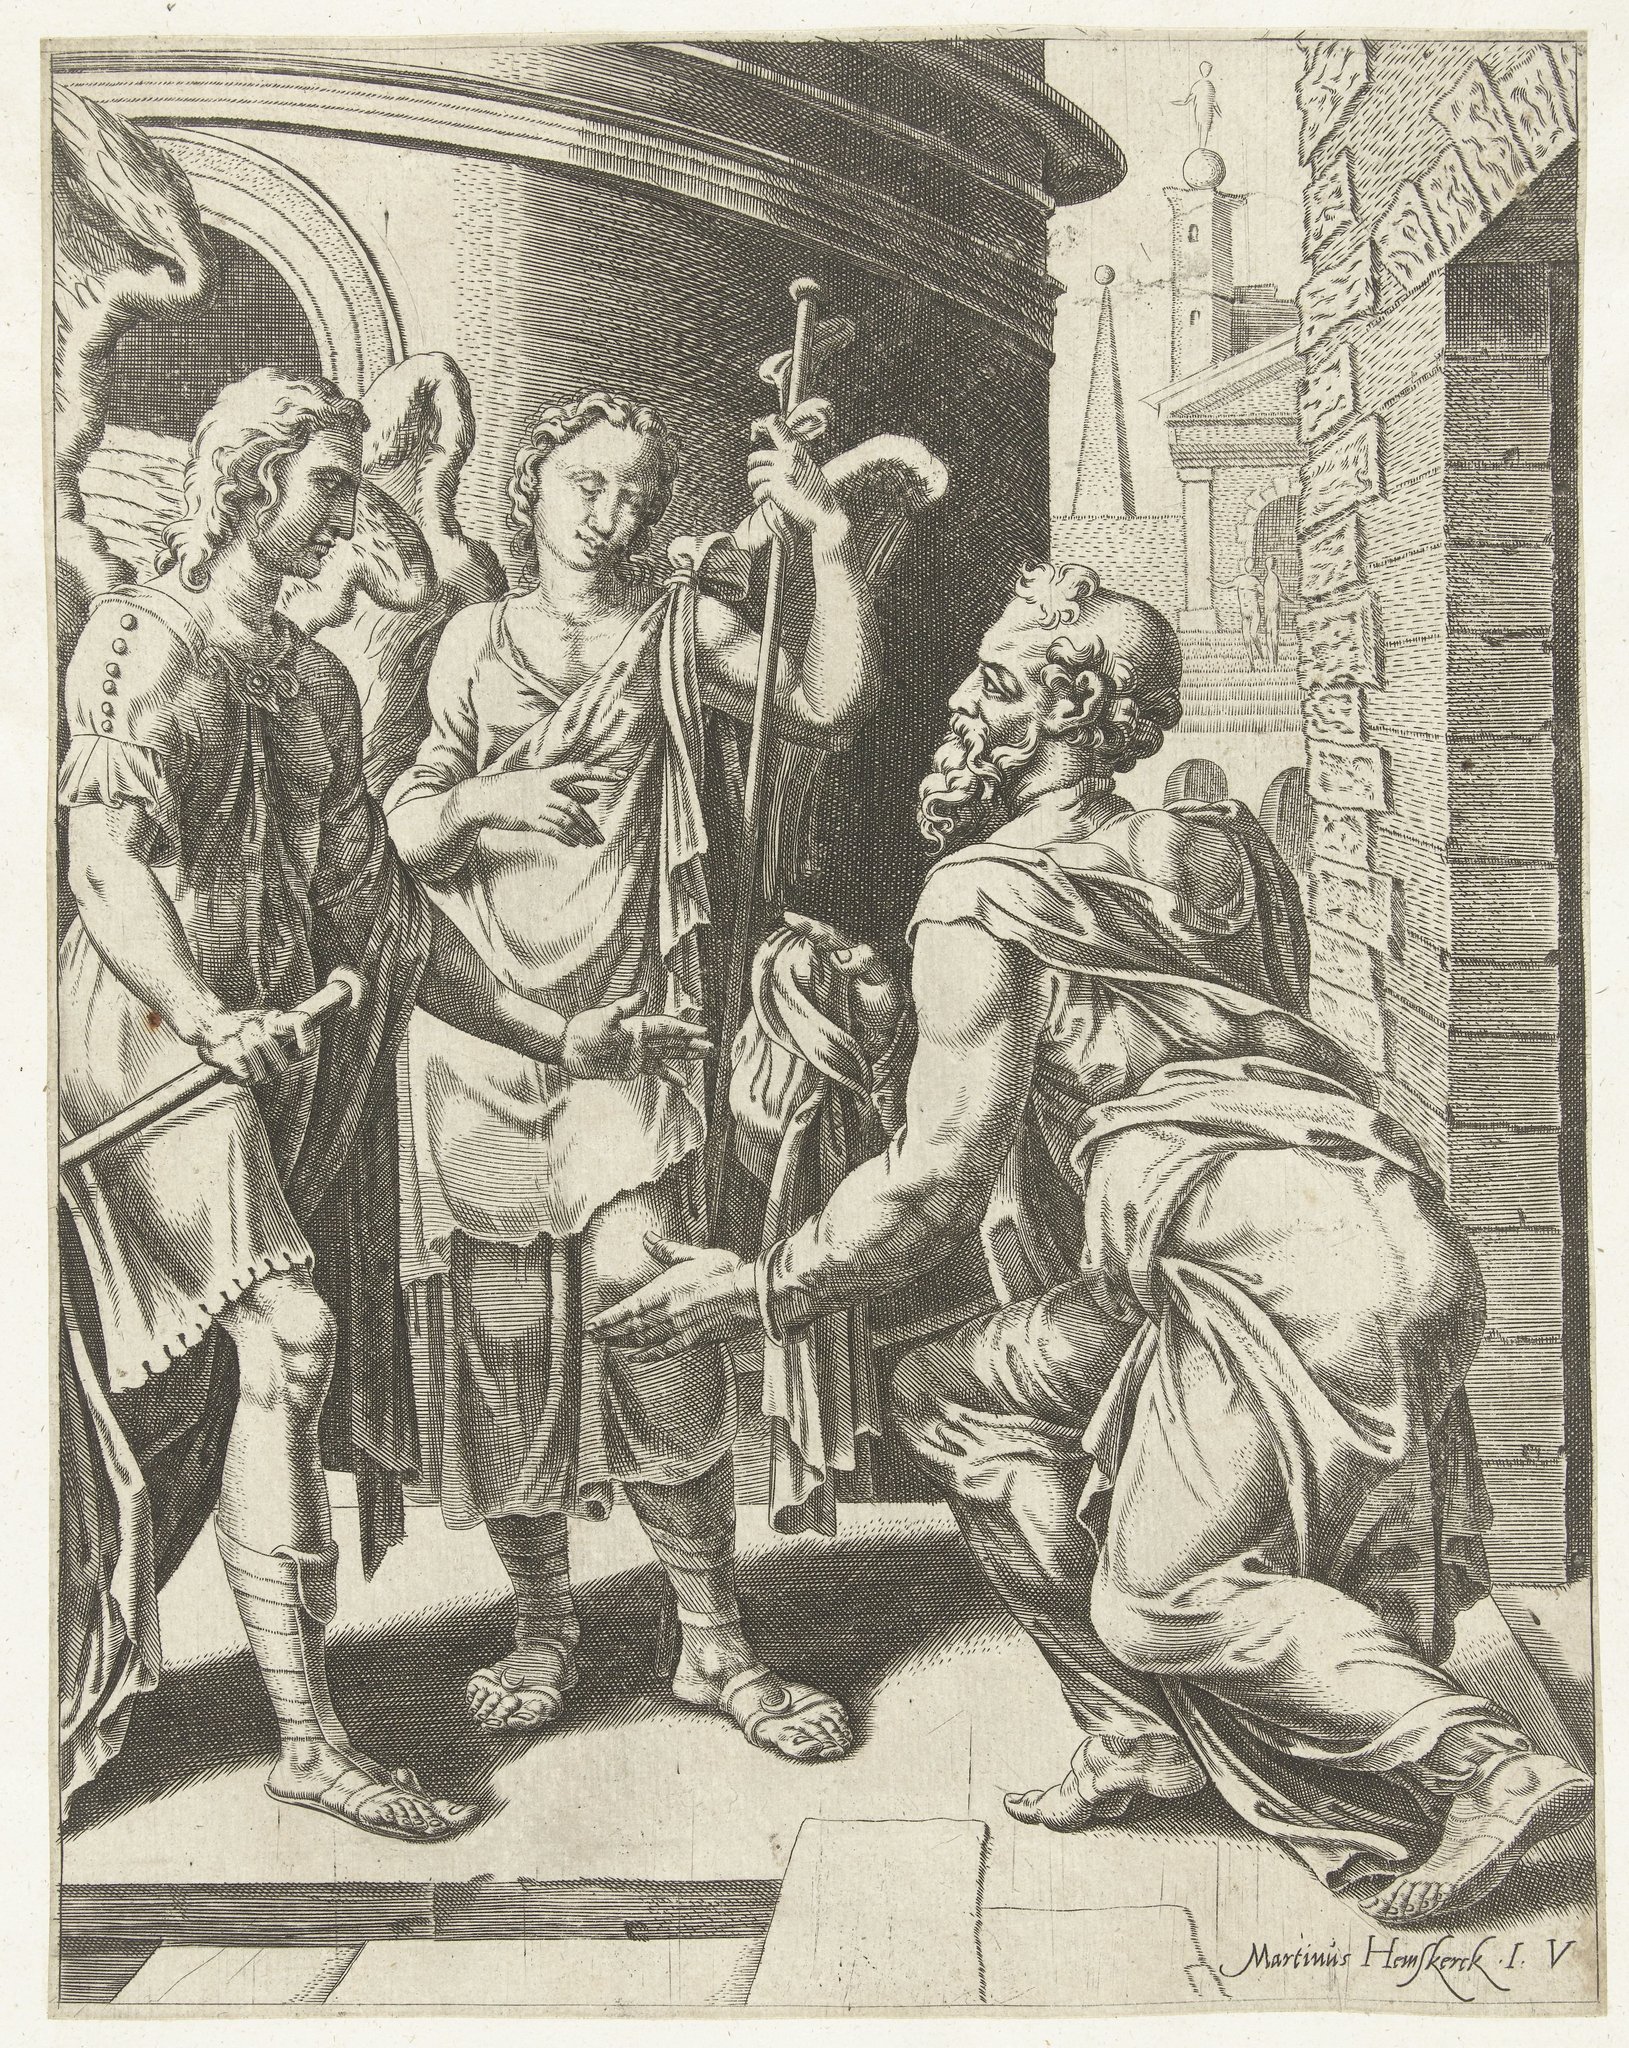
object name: print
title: De geschiedenis van Lot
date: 1551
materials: paper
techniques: engraving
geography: groningen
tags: the angels find lot sitting at the gateway of the city; he arises and kneels before them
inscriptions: collector's mark: Lugt 2228, collector's mark: Lugt 2760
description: Lot wacht voor de stadspoort op de twee engelen en nodigt ze uit bij hem in huis te eten en te overnachten.